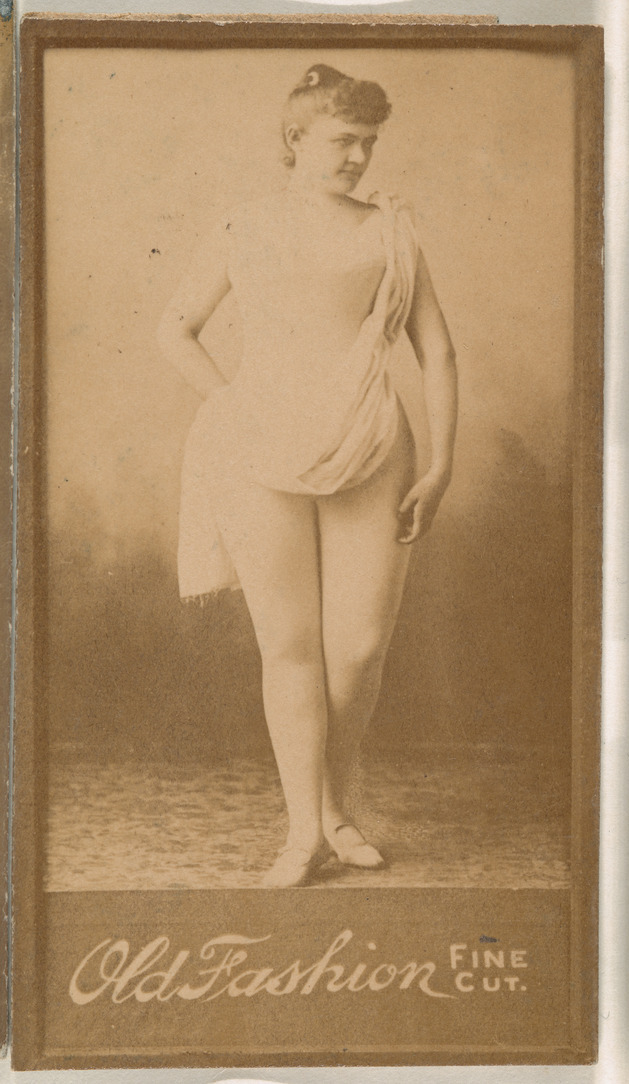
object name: photograph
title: Portrait of actress, from the Actresses series (N664) promoting Old Fashion Fine Cut Tobacco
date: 1888-1890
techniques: albumen silver print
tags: portraits,women,actresses